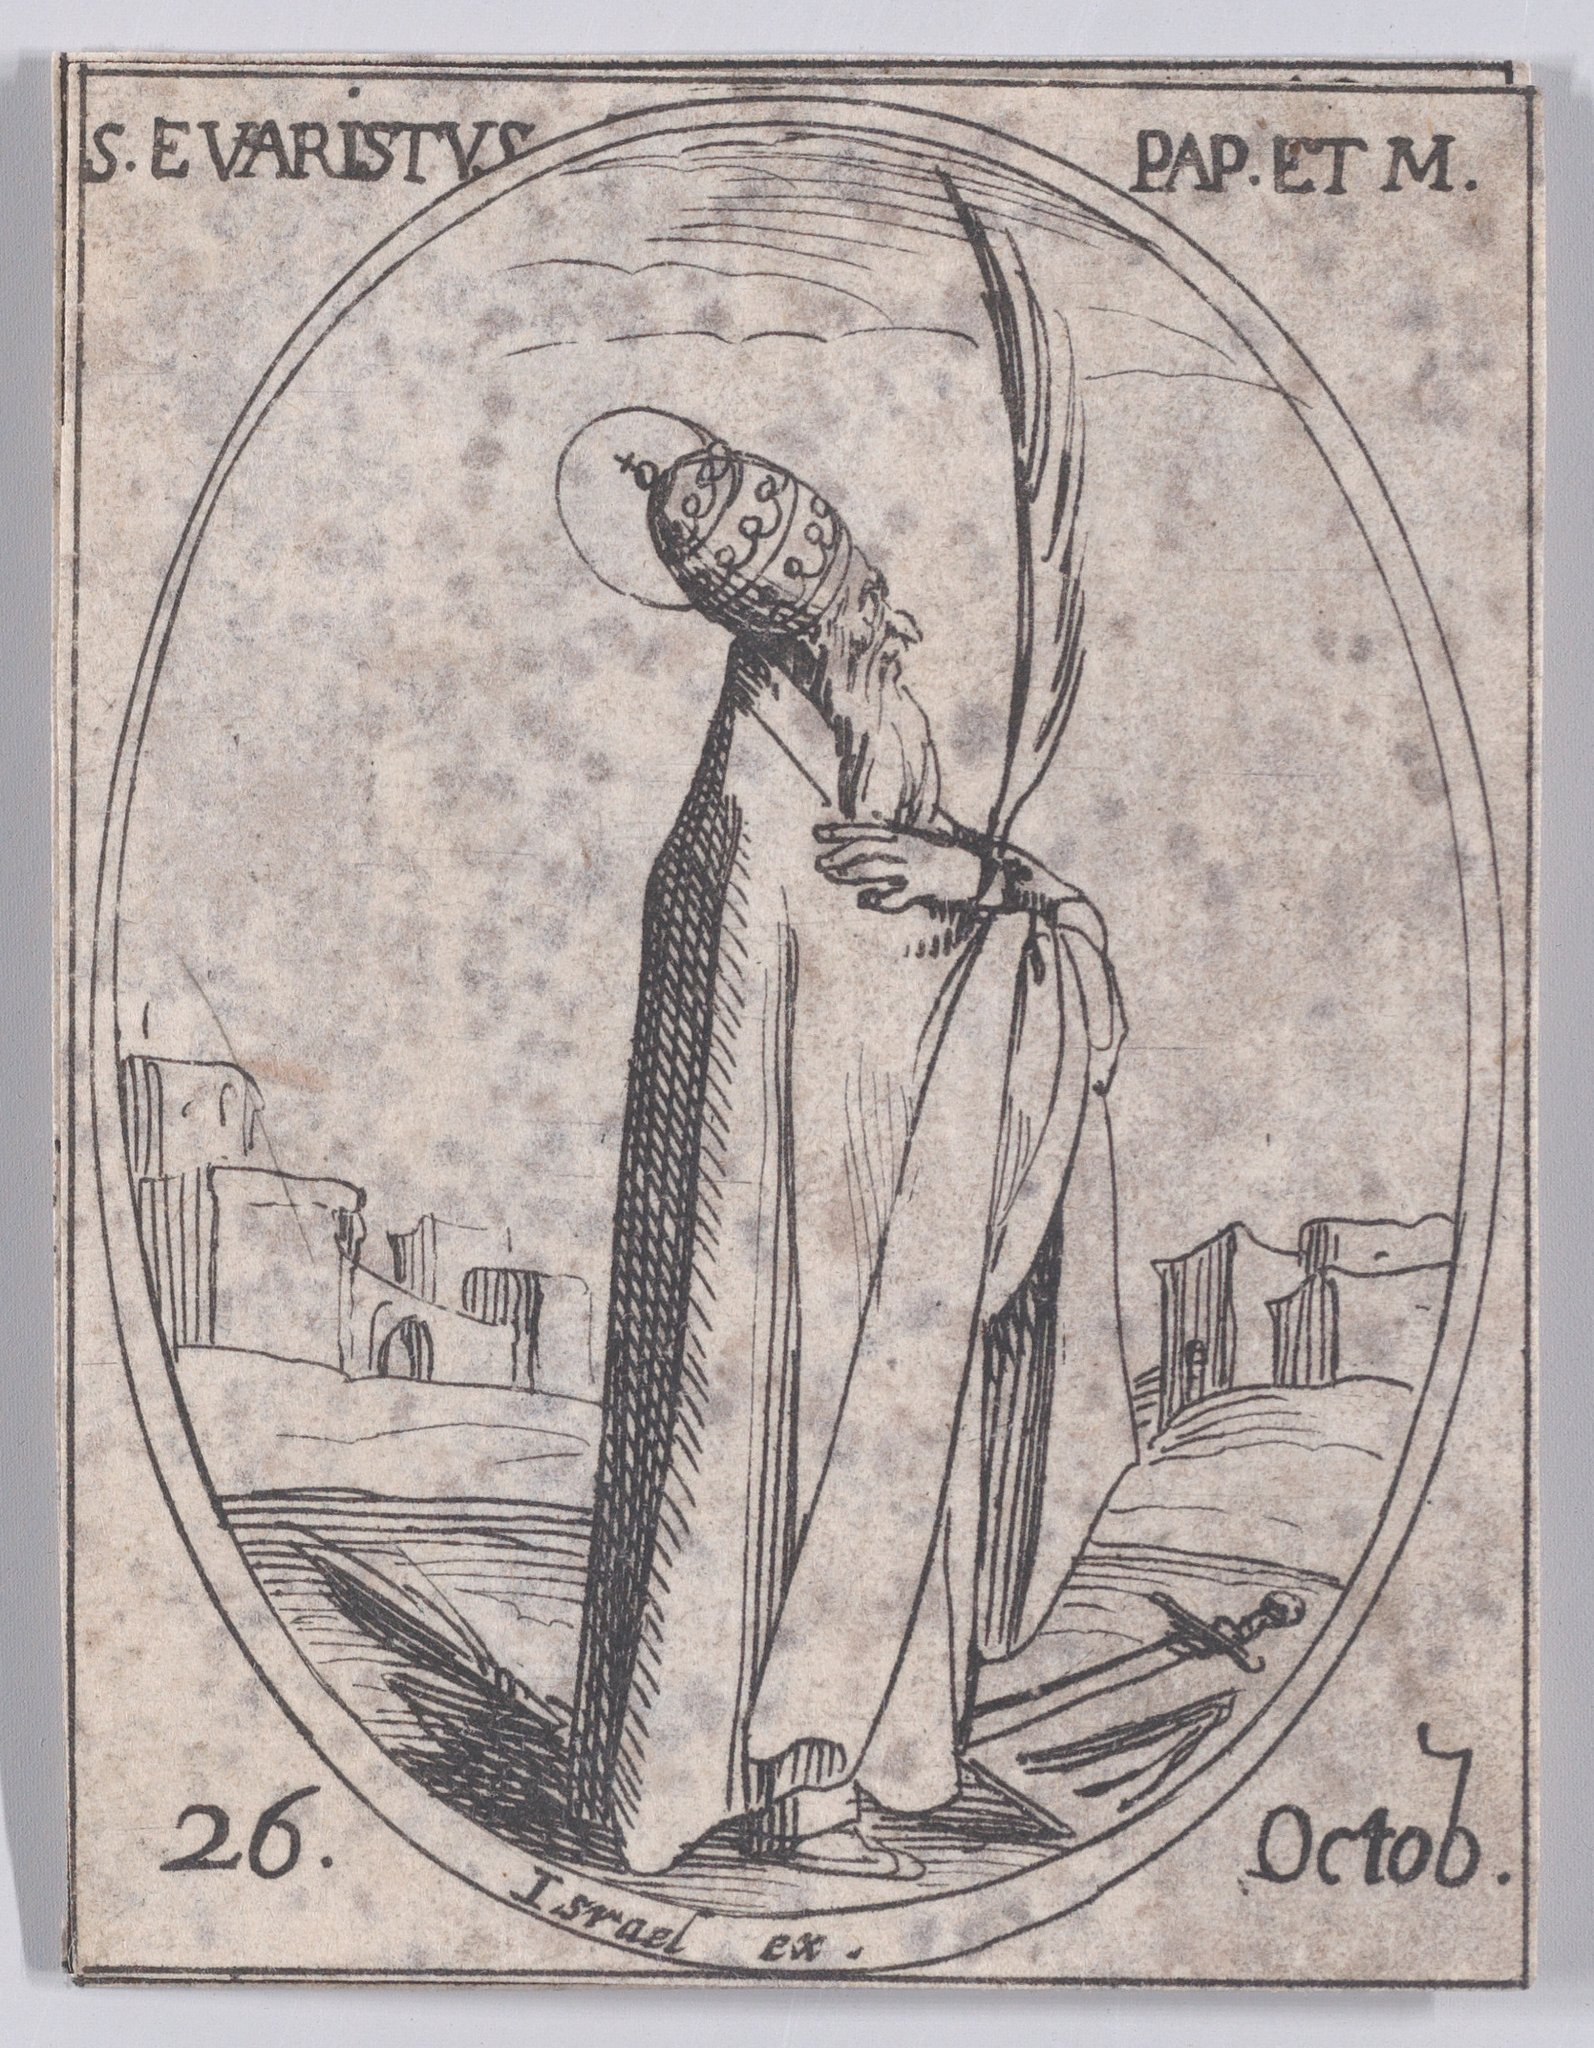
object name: print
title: S. Evariste, pape et martyr (St. Evaristus, Pope and Martyr), October 26th, from "Les Images De Tous Les Saincts et Saintes de L'Année" (Images of All of the Saints and Religious Events of the Year)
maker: jacques callot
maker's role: artist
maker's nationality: french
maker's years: 1592-1635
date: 1636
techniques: etching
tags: men,saints